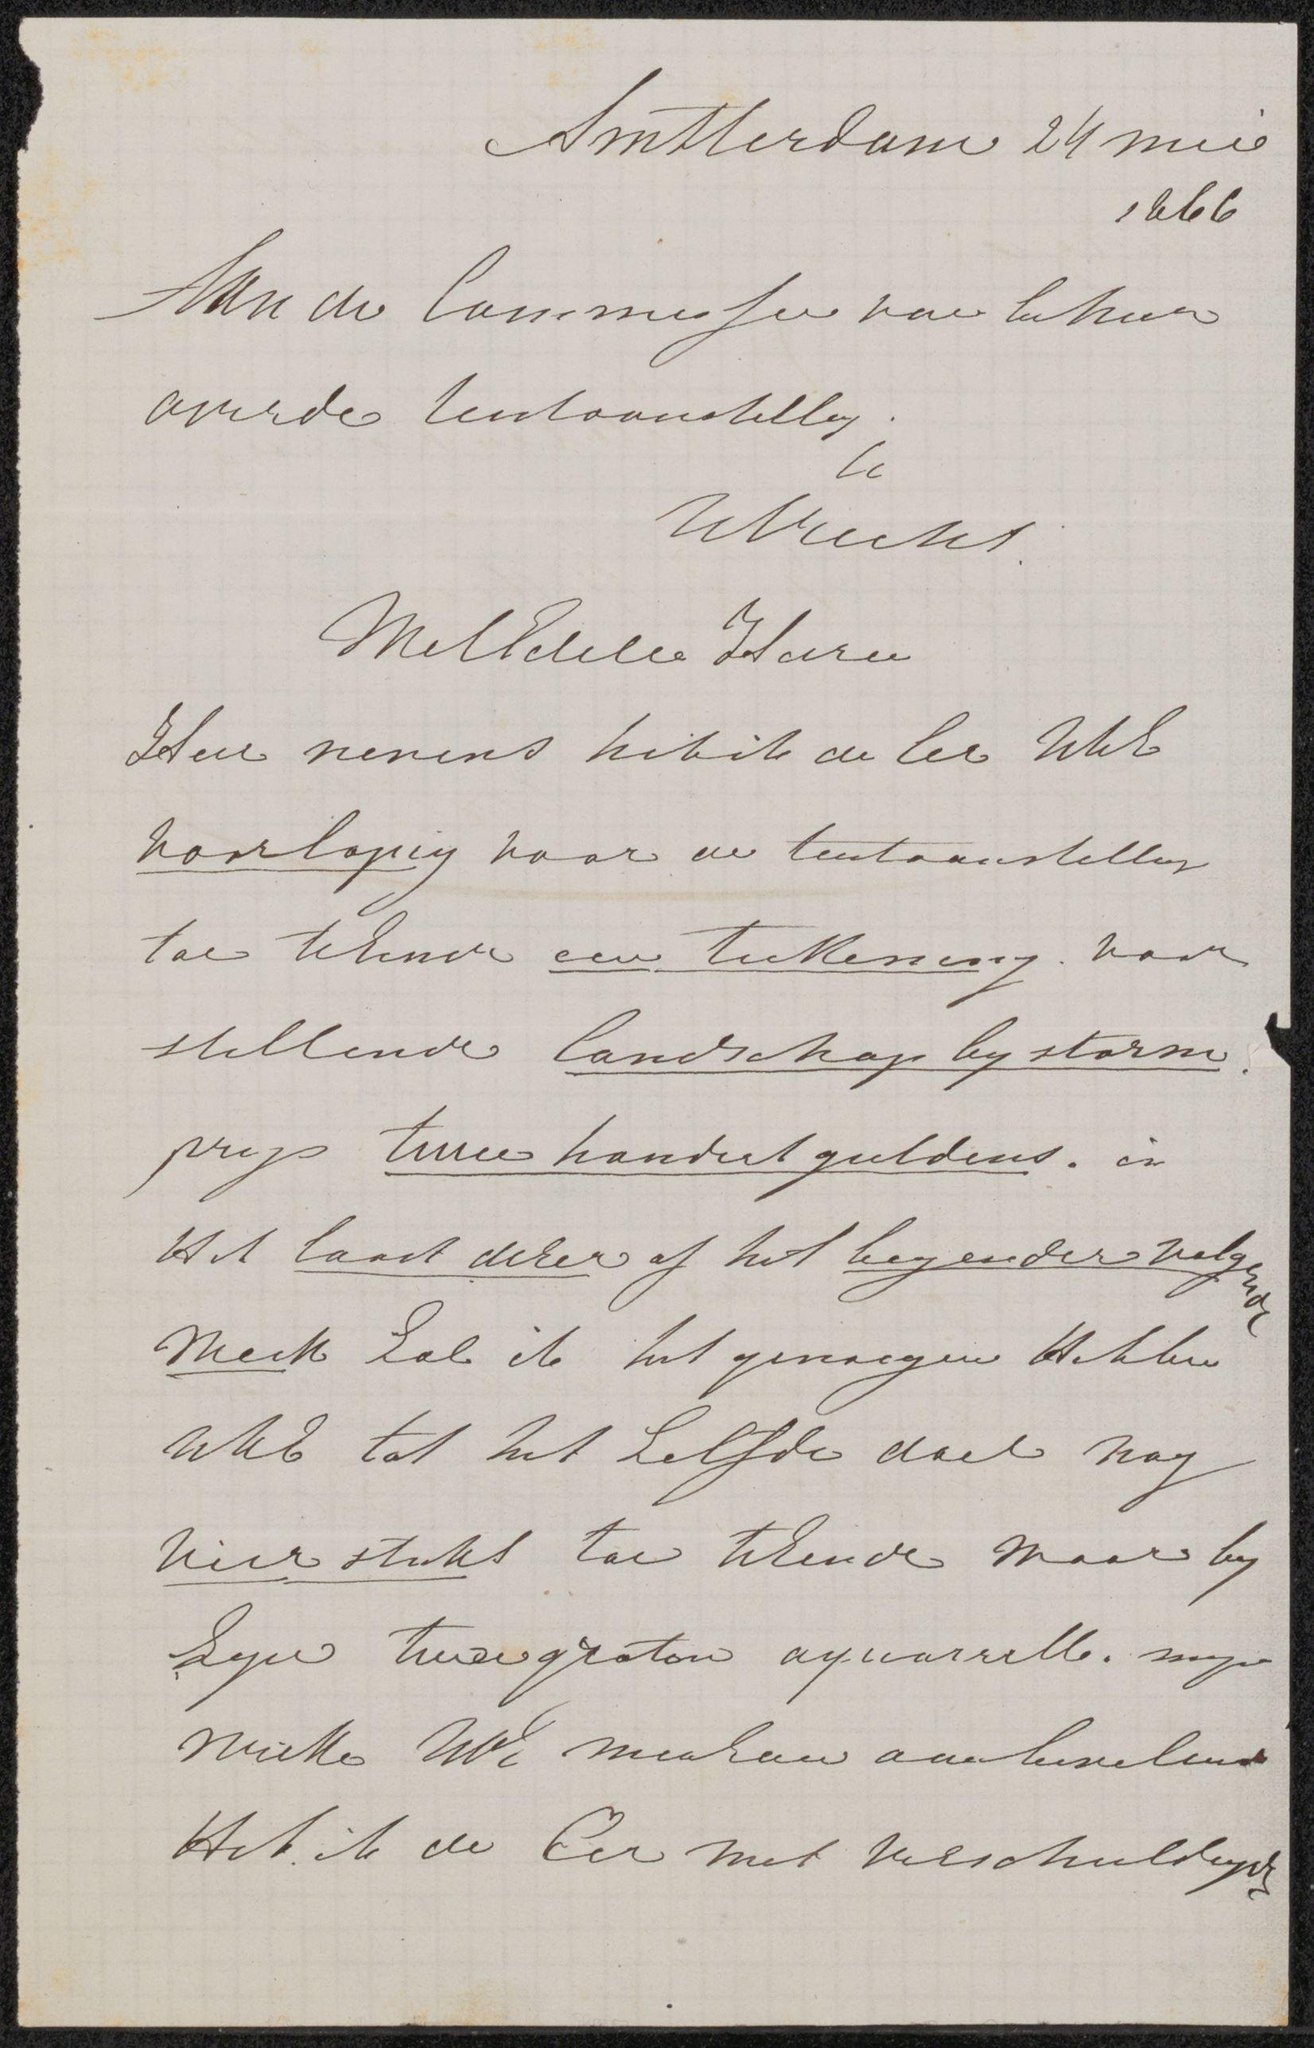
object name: letter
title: Brief aan de commissie van de Tentoonstelling van Levende Meesters in Utrecht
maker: johannes hilverdink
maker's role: draughtsman, painter, print maker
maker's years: 1813-1902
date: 1866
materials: ink, paper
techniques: pen, writing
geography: amsterdam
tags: drawing, exhibition ~ art, money